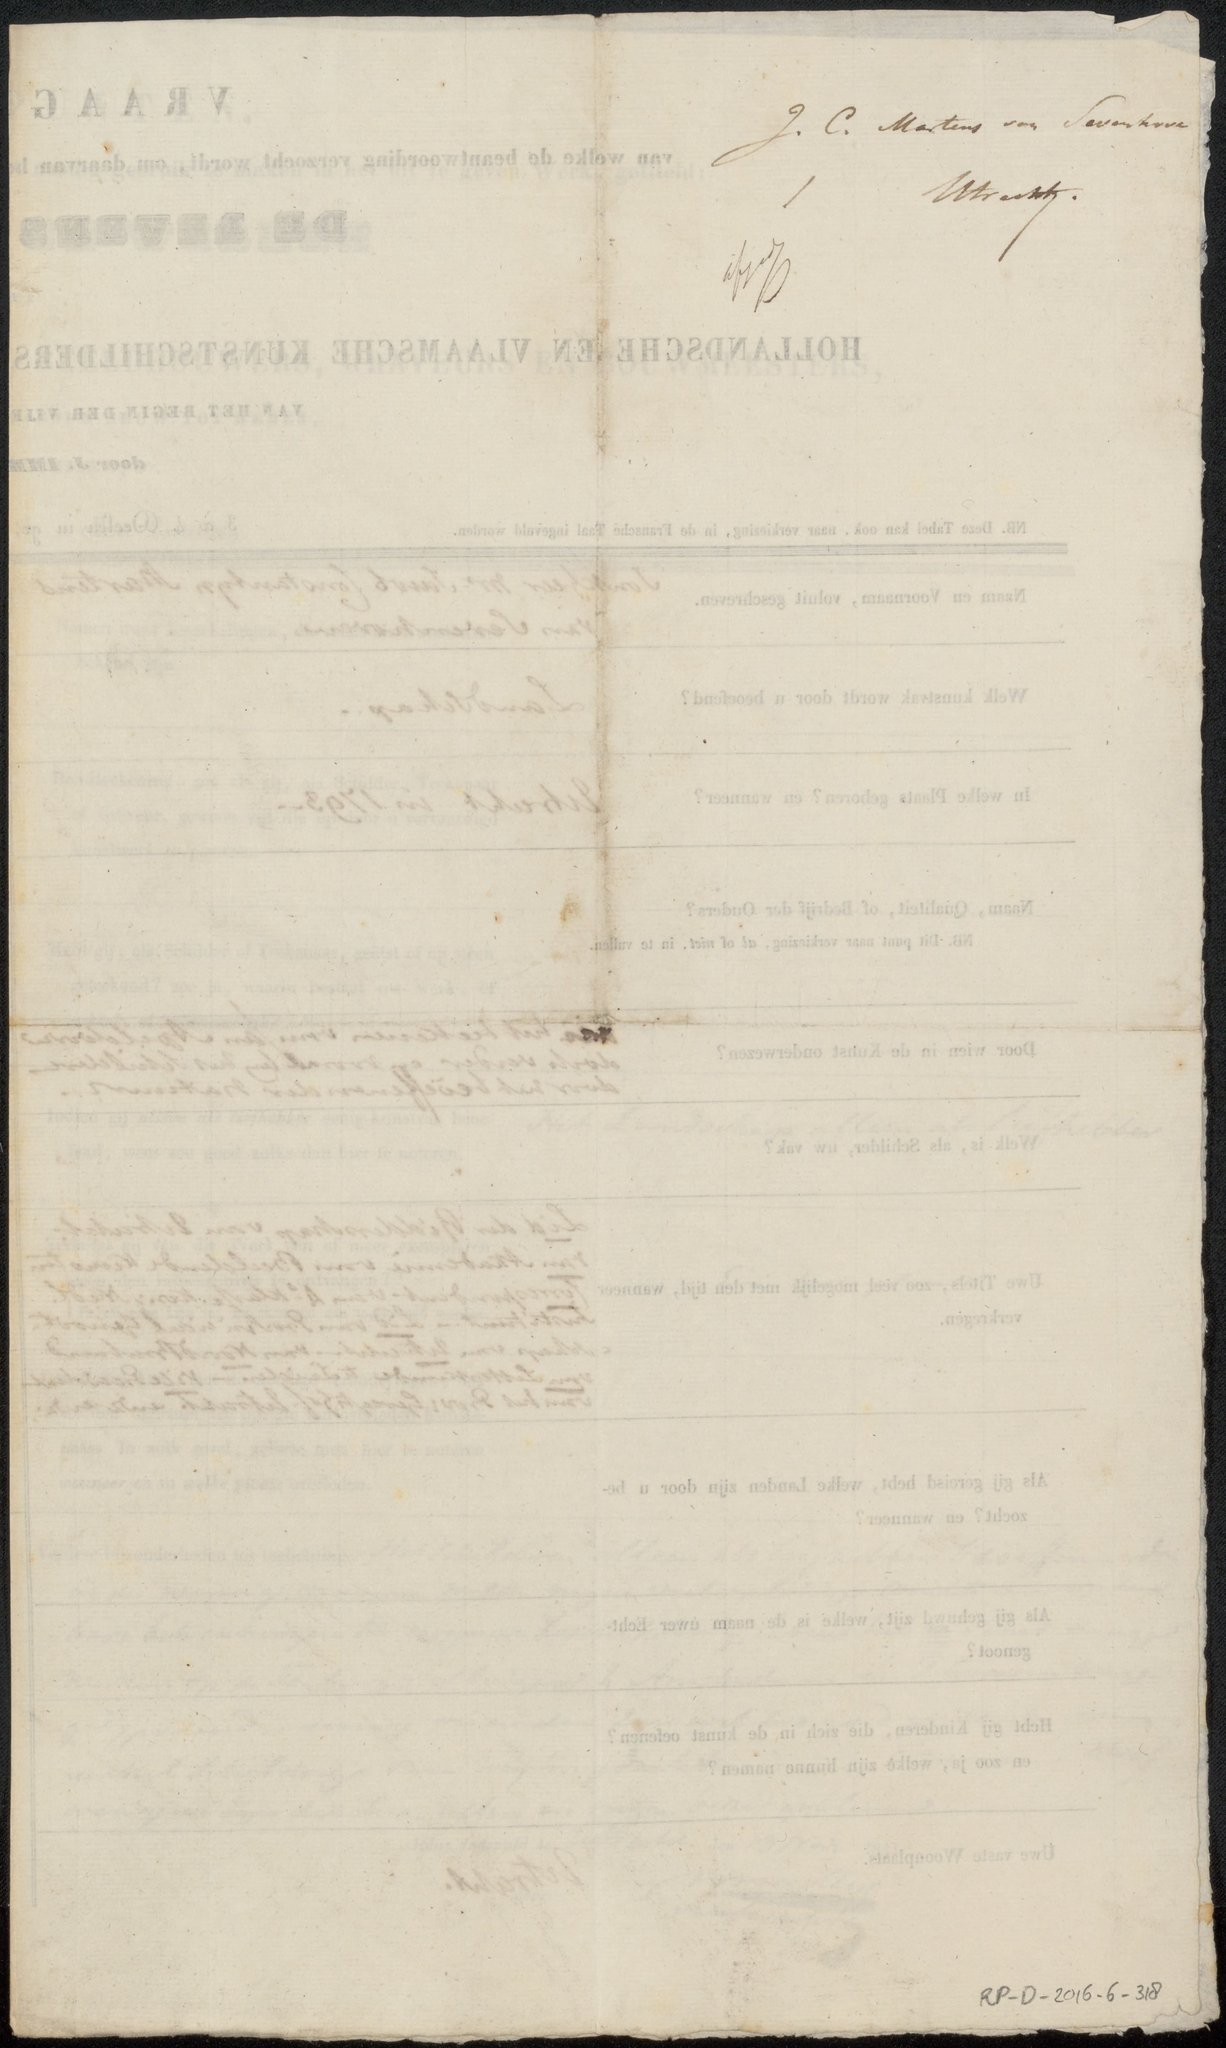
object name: questionnaire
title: Enquêteformulier ingevuld door jonkheer Jacob Constantijn Martens van Sevenhoven (1793-1861)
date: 1841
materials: ink, paper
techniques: pen, printing, writing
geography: utrecht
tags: utrecht, jonkheer jacob constantijn martens van sevenhoven (1793-1861)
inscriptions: watermark, inscription: ‘Vraagpunten,/ van welke de beantwoording verzocht wordt, om daarvan het noodig gebruik te maken in het uit te geven Werk, getiteld: De levens en werken/ der Hollandsche en Vlaamsche kunstschilders, beeldhouwers,/ graveurs en bouwmeesters, van het begin der vijftiende eeuw tot heden/ door J. Immerzeel, Jr.’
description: Opgenomen in: Immerzeel, J. Jr., De levens en werken der Hollandsche en Vlaamsche kunstschilders, beeldhouwers, graveurs en bouwmeesters, van het begin der vijftiende eeuw tot heden, Amsterdam: J.C. van Kesteren, 1842-1843.